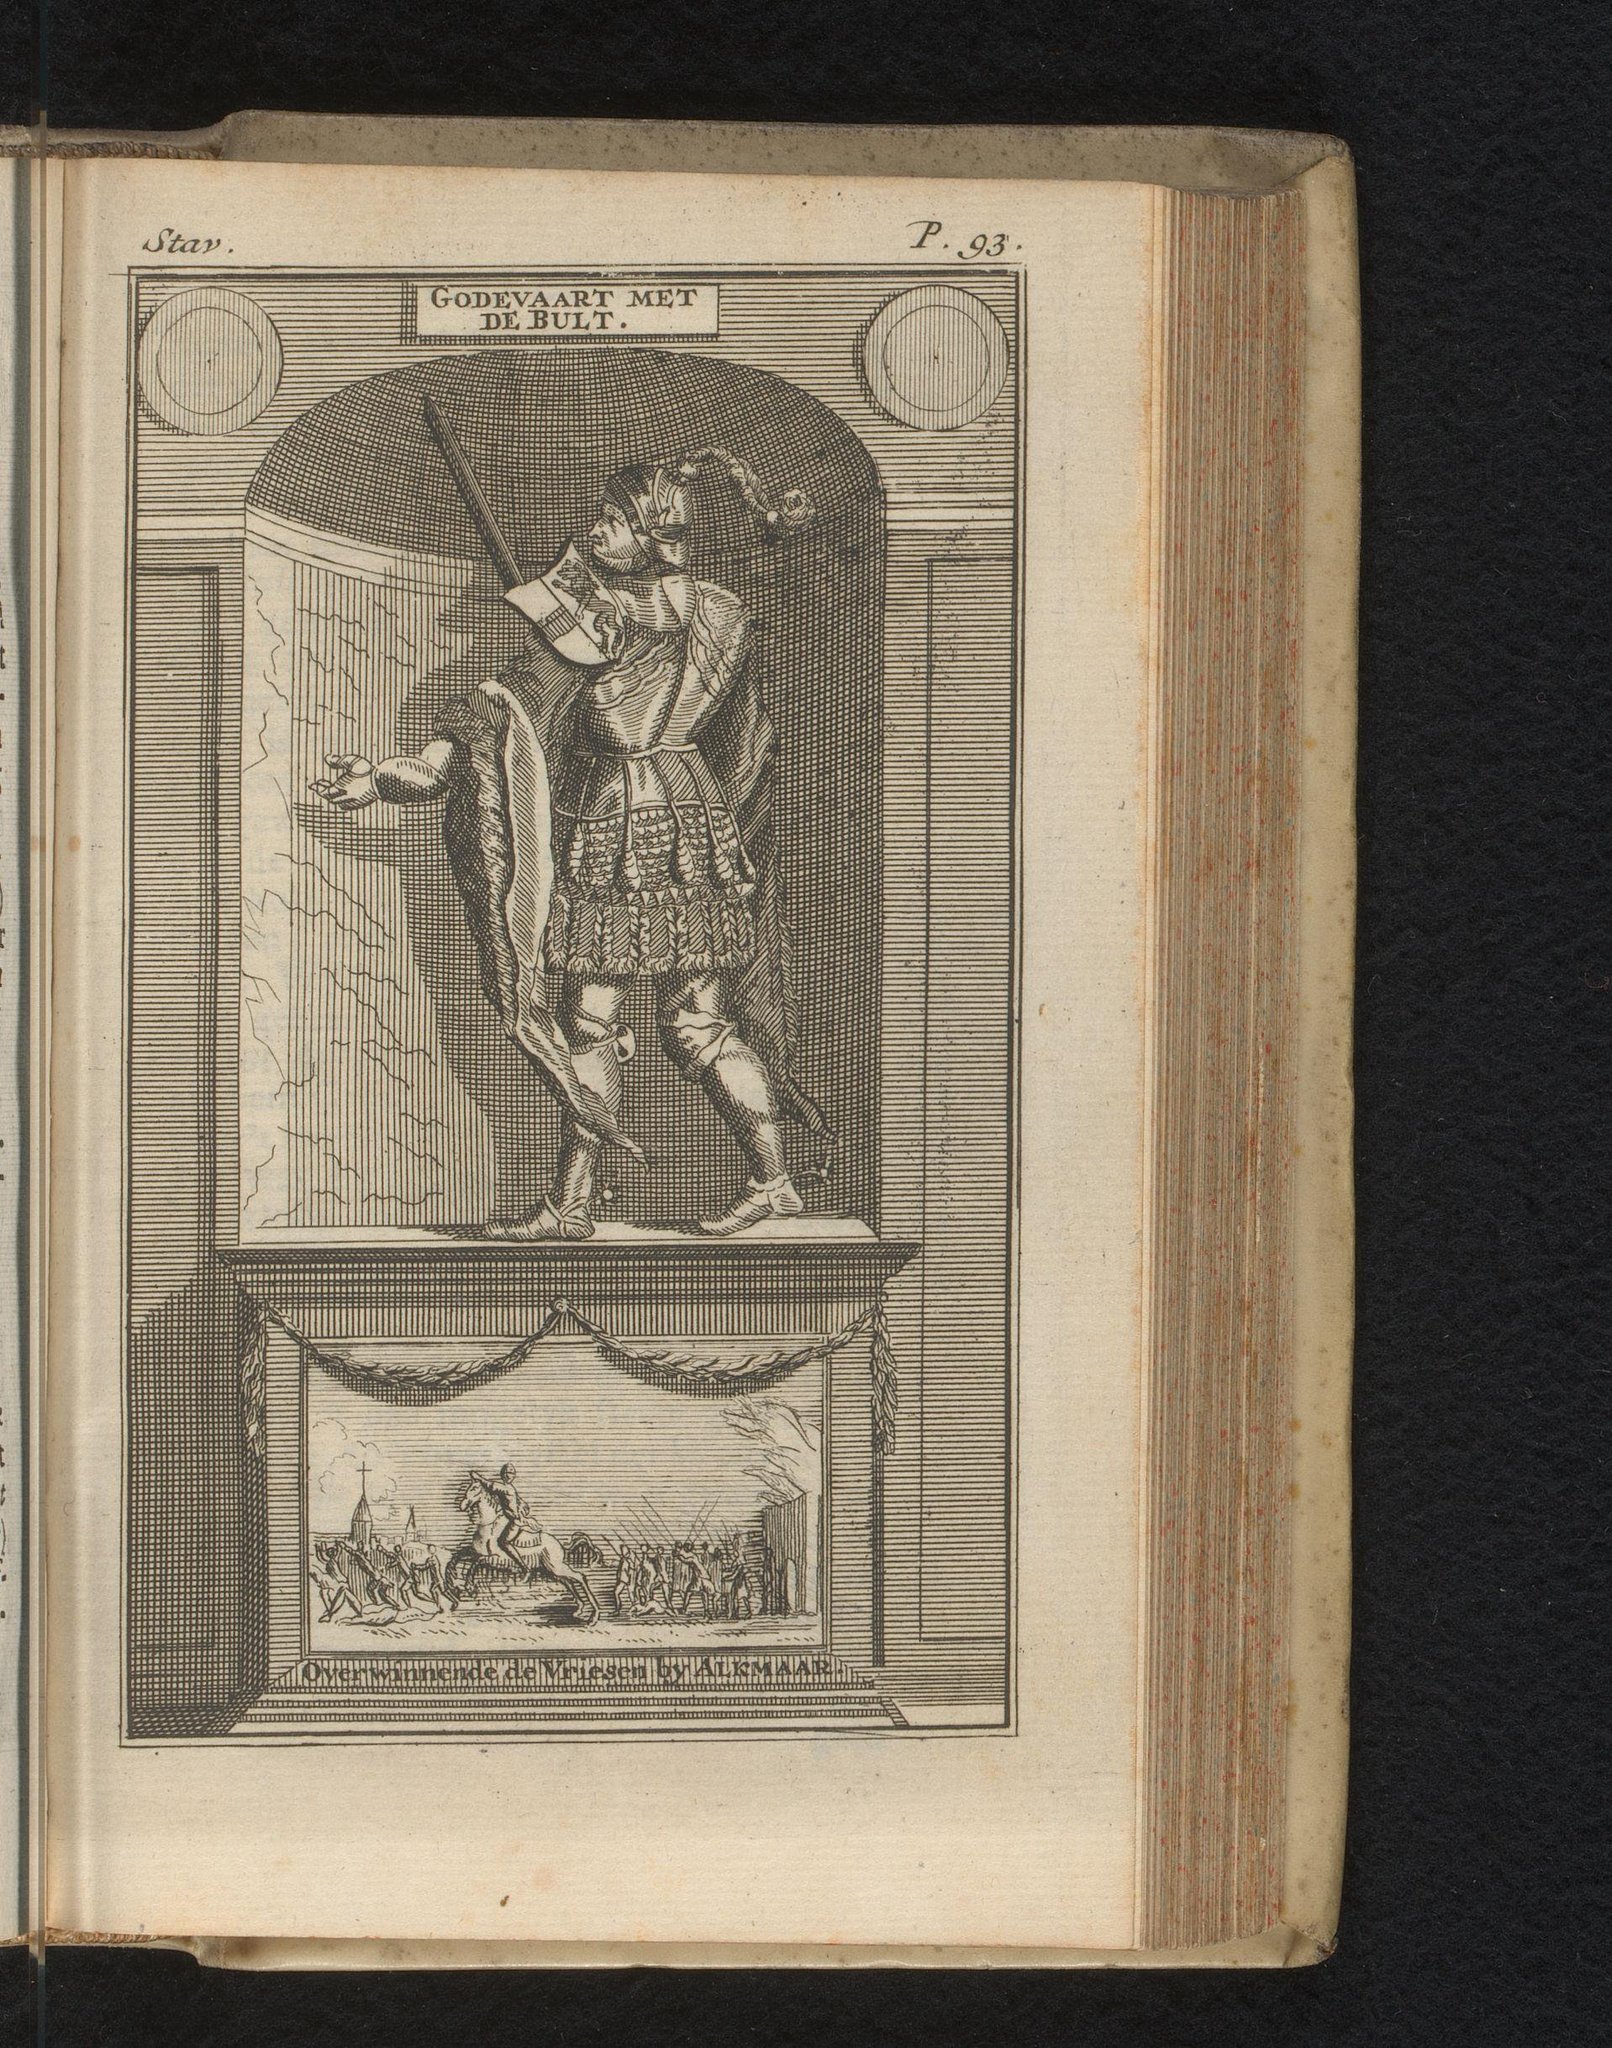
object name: history print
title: Godfried III met de Bult verslaat de Friezen bij Alkmaar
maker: pieter van den berge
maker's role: draughtsman, print maker, printer, publisher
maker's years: 1659-1737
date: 1700-1702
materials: paper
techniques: etching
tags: godfried iii met de bult (hertog van neder-lotharingen), alkmaar, stavoren, nederland tijdens de late middeleeuwen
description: Illustratie in: H. Soeteboom, Oud-heden van Zaan-land, Stavoren, Vronen en Waterland : deze laatste druk ... met nodige aanteekeningen, figuren, en een landkaart verrykt / Op- en neder-gank van Stavoren, in VI. Boeken verdeelt, W. Linnig van Koppenol, Amsterdam 1702, ingebonden tussen p. 92/93.